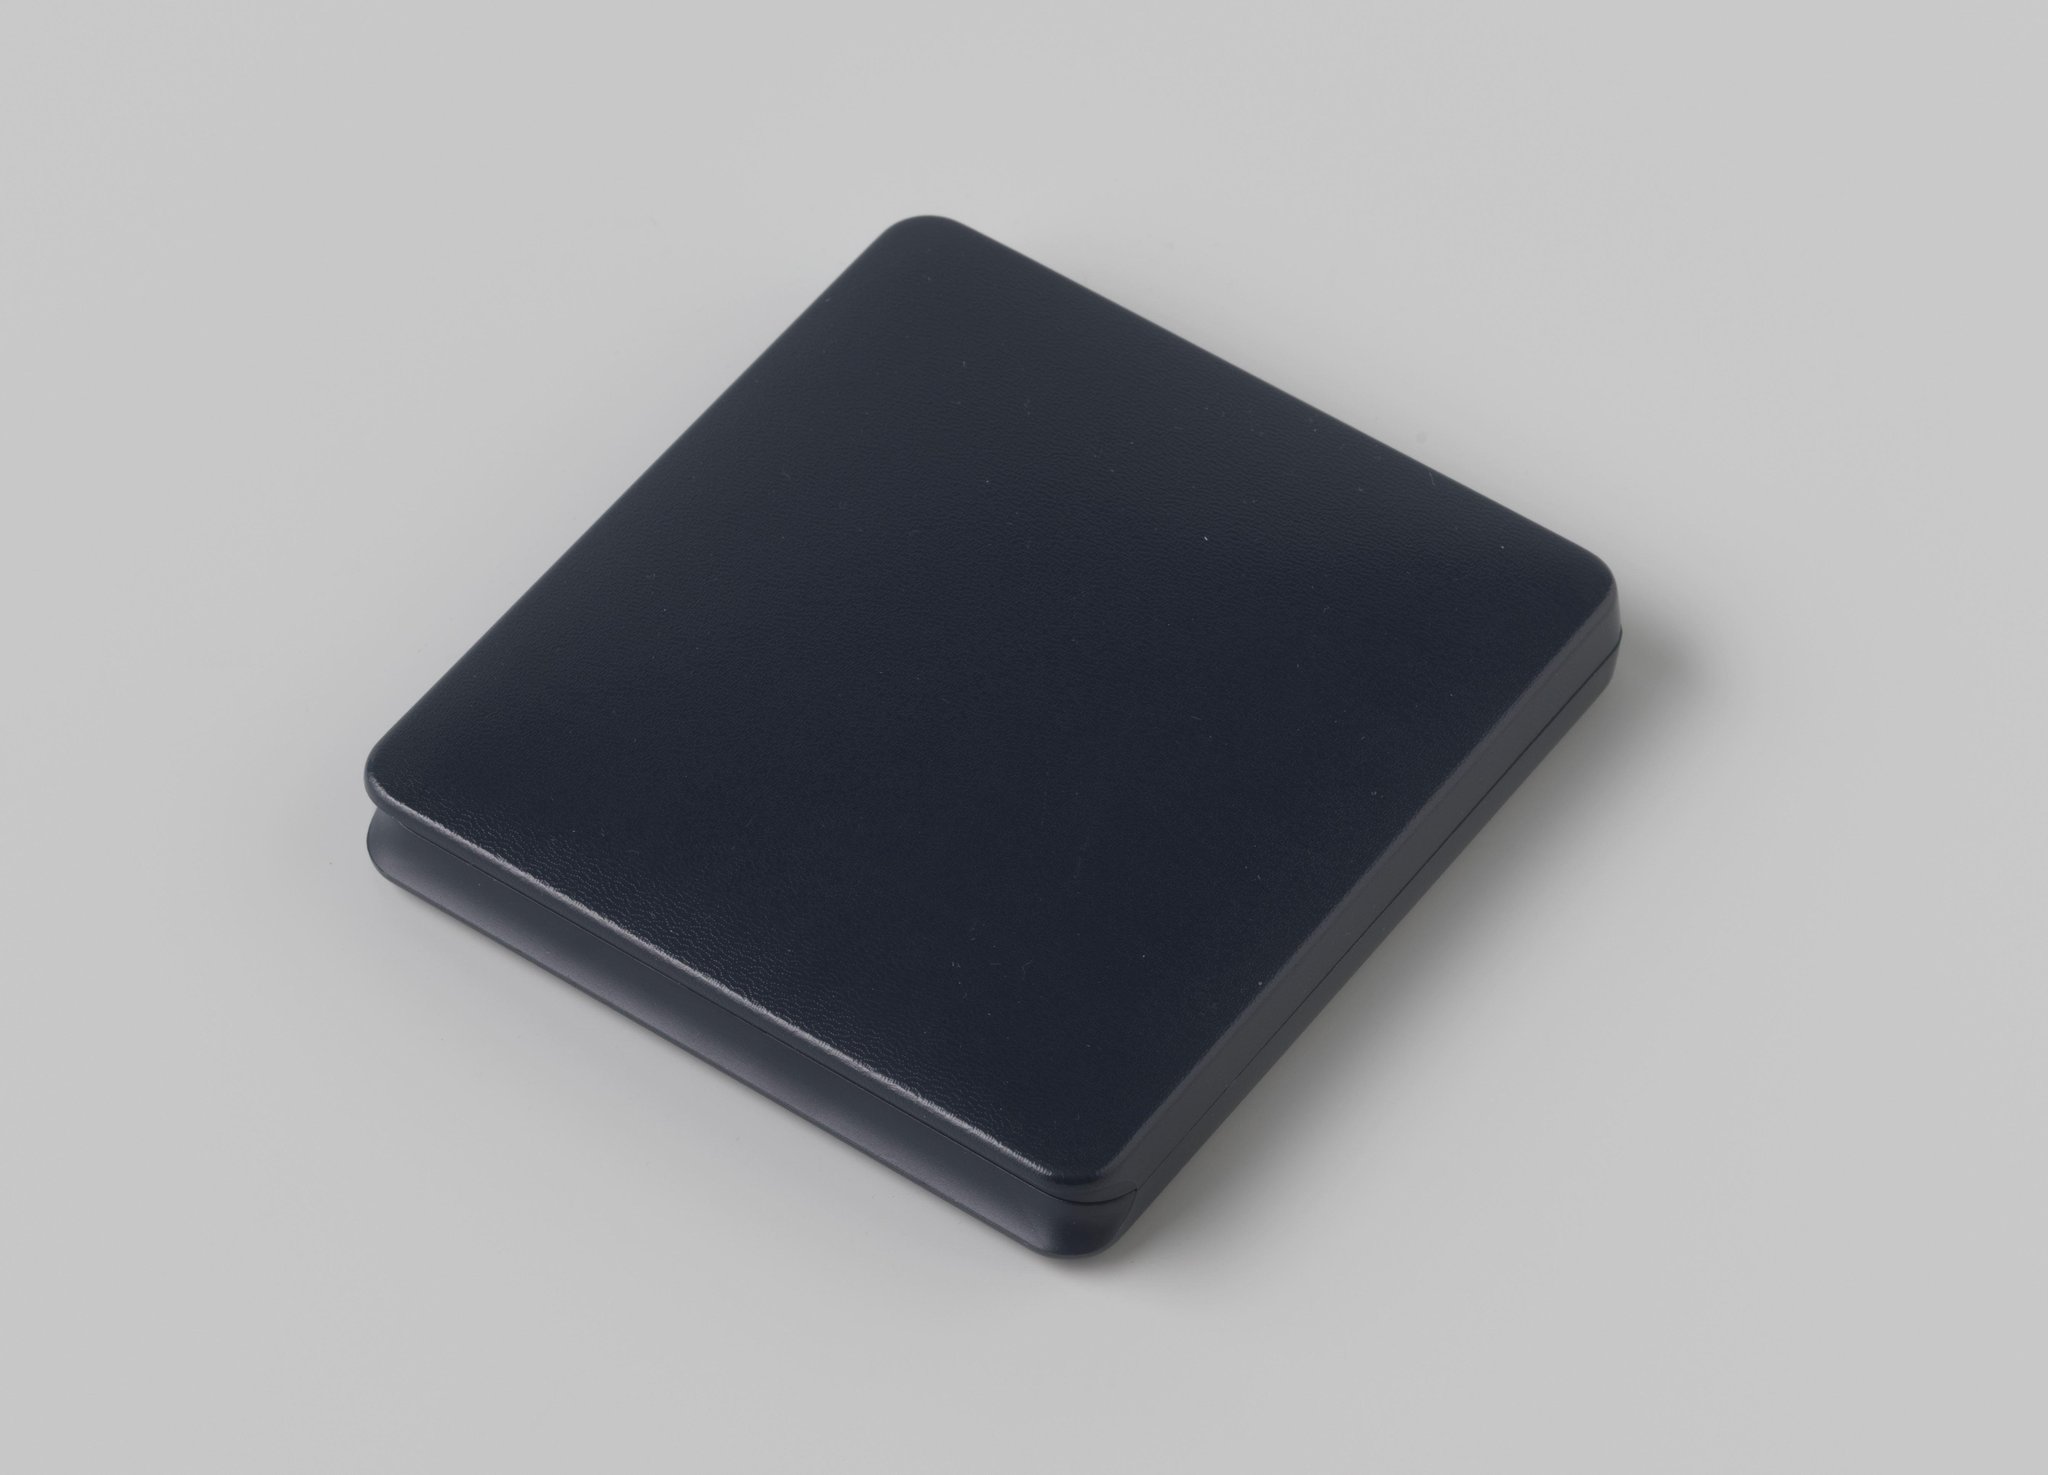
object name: box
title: Doosje voor de penning in het kader van Honderd jaar Koninklijk Nederlands Genootschap voor munt- en penningkunde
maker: marianne letterie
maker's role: sculptor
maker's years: 1945-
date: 1992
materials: plastic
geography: amsterdam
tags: amsterdam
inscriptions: inscription: ‘Penningdoos: binnenzijde van deksel, omschrift: KONINKLIJK NED. GENOOTSCHAP VOOR MUNT- EN PENNINGKUNDE Centraal: Concordia Res / Parvae Crescunt 1892 1992’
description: Doosje van kunststof voor het opbergen van de penning, uitgegeven in het kader van Honderd jaar Koninklijk Nederlands Genootschap voor munt- en penningkunde. Binnezijde deksel inscriptie.